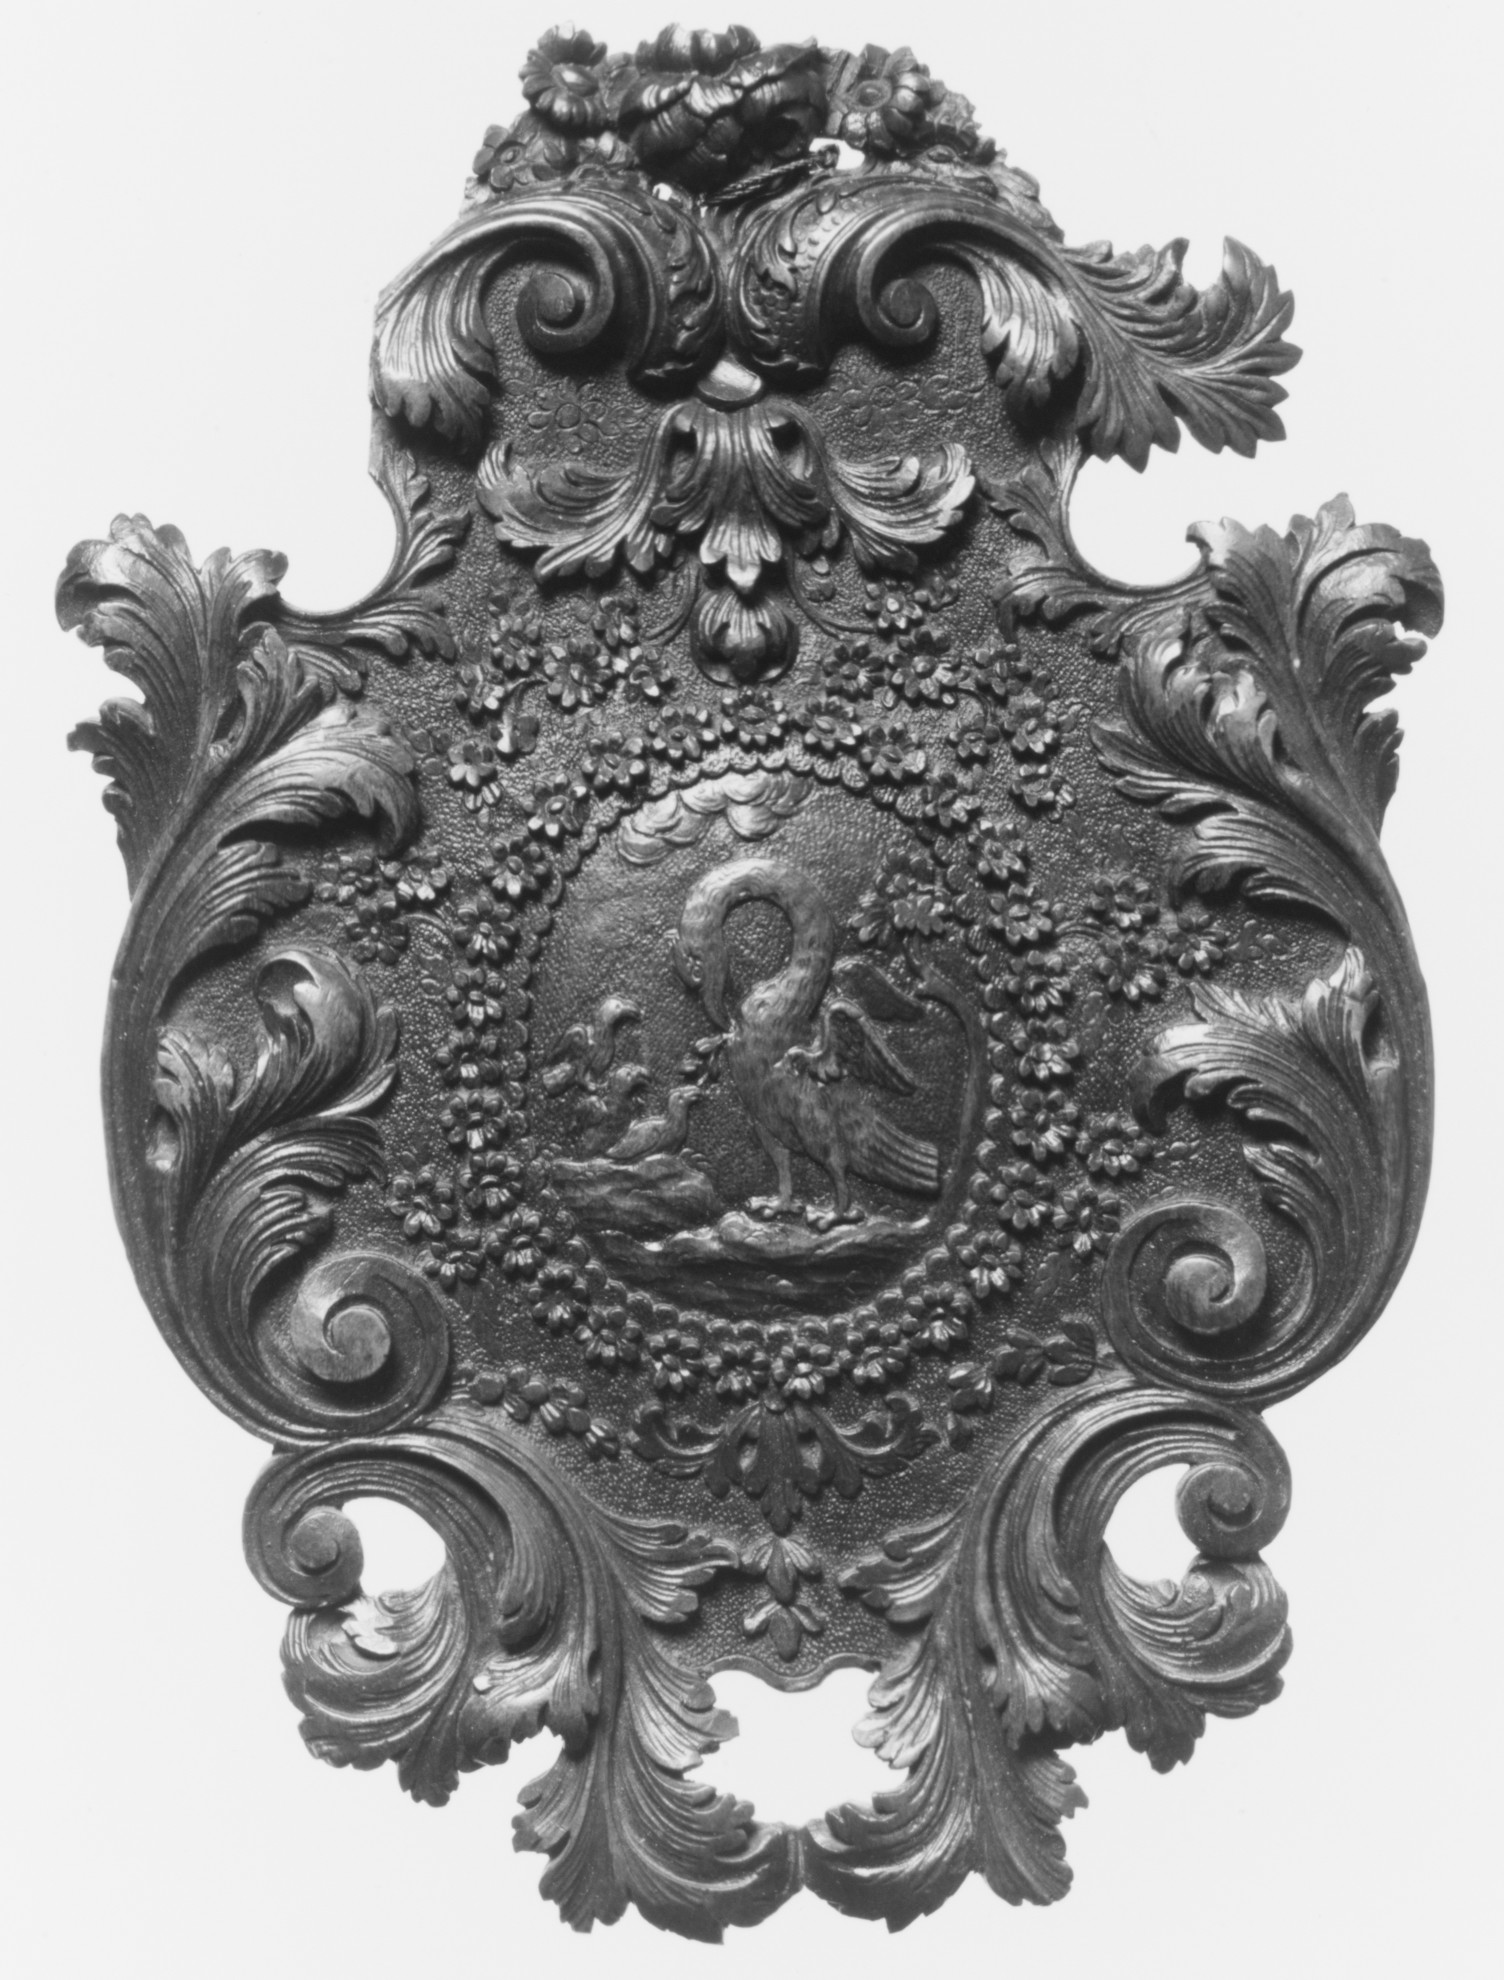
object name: plaque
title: Piety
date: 1700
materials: wood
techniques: carving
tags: cranes,flowers